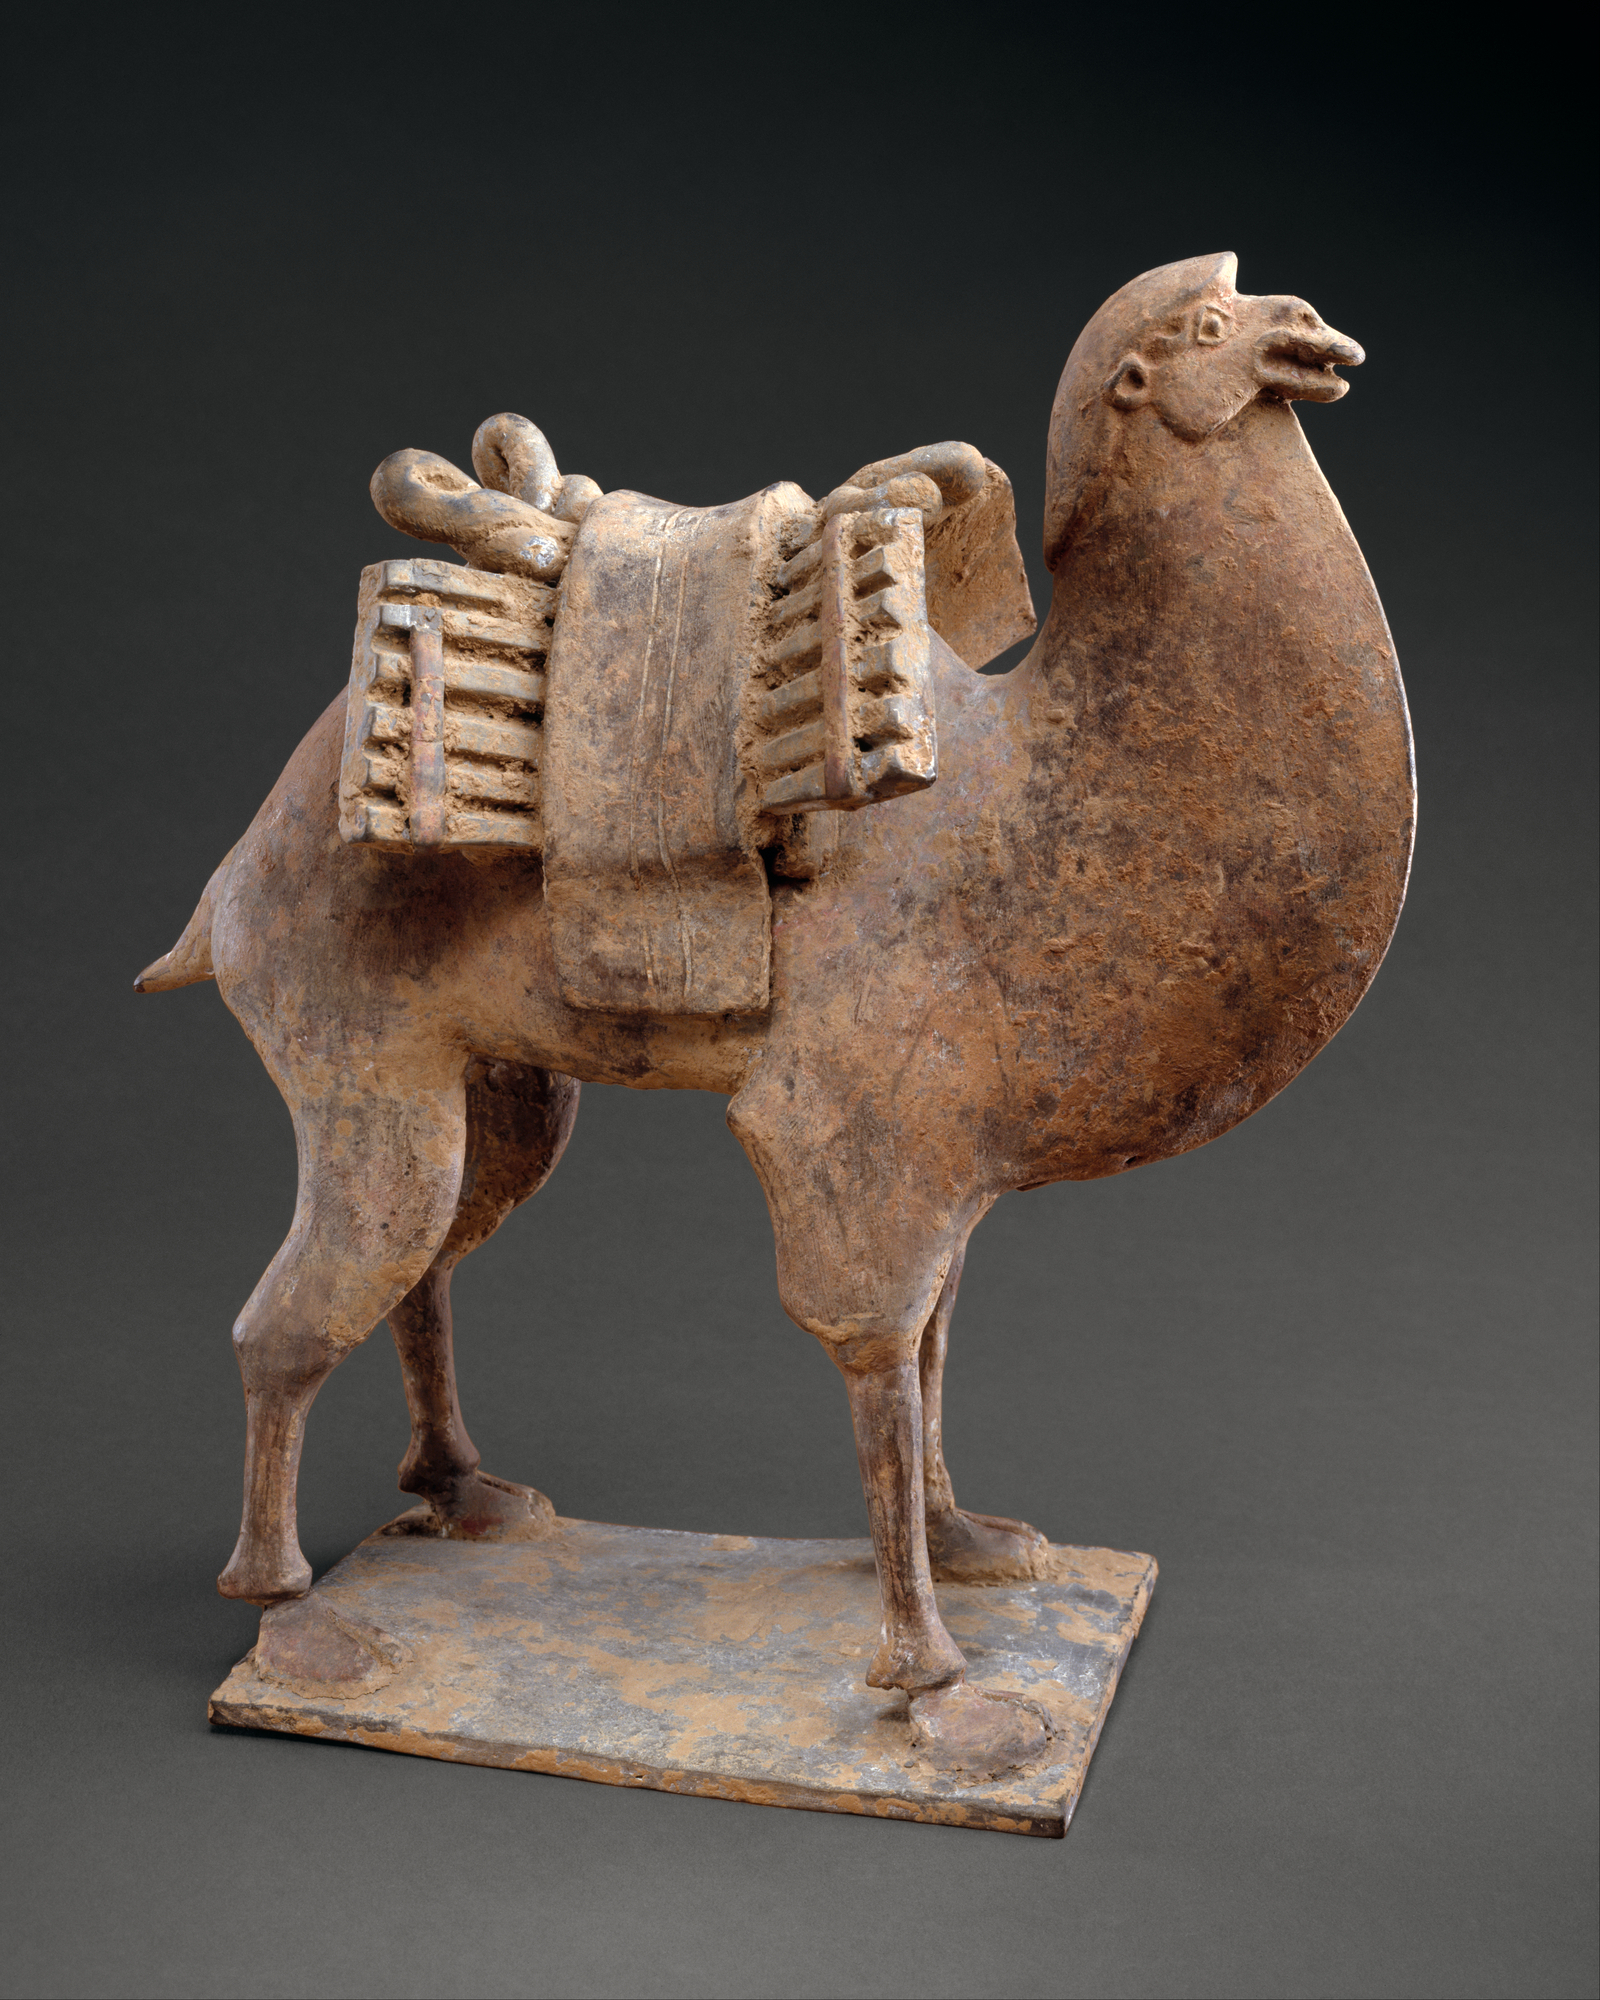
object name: figure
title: Camel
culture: chinese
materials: earthenware, pigment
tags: camels